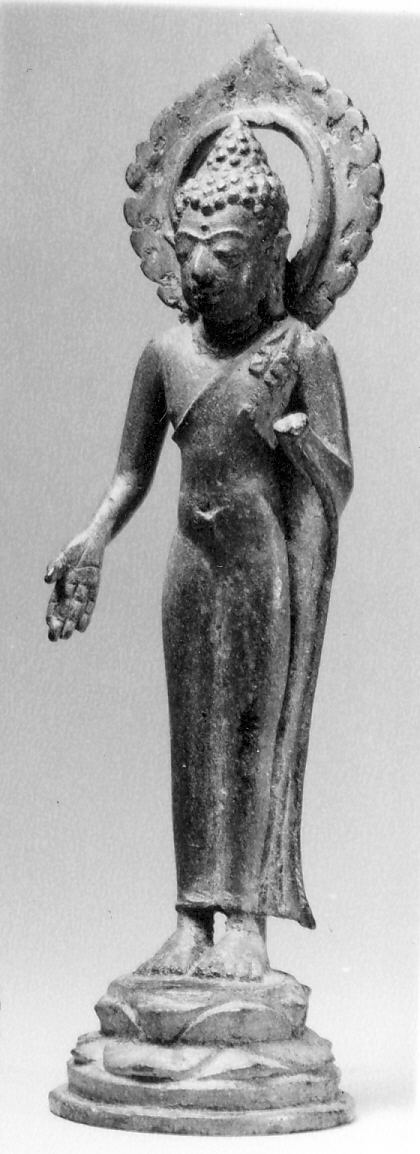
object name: figure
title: Standing Buddha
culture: indonesian, javanese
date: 801-900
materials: bronze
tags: buddhism,buddha